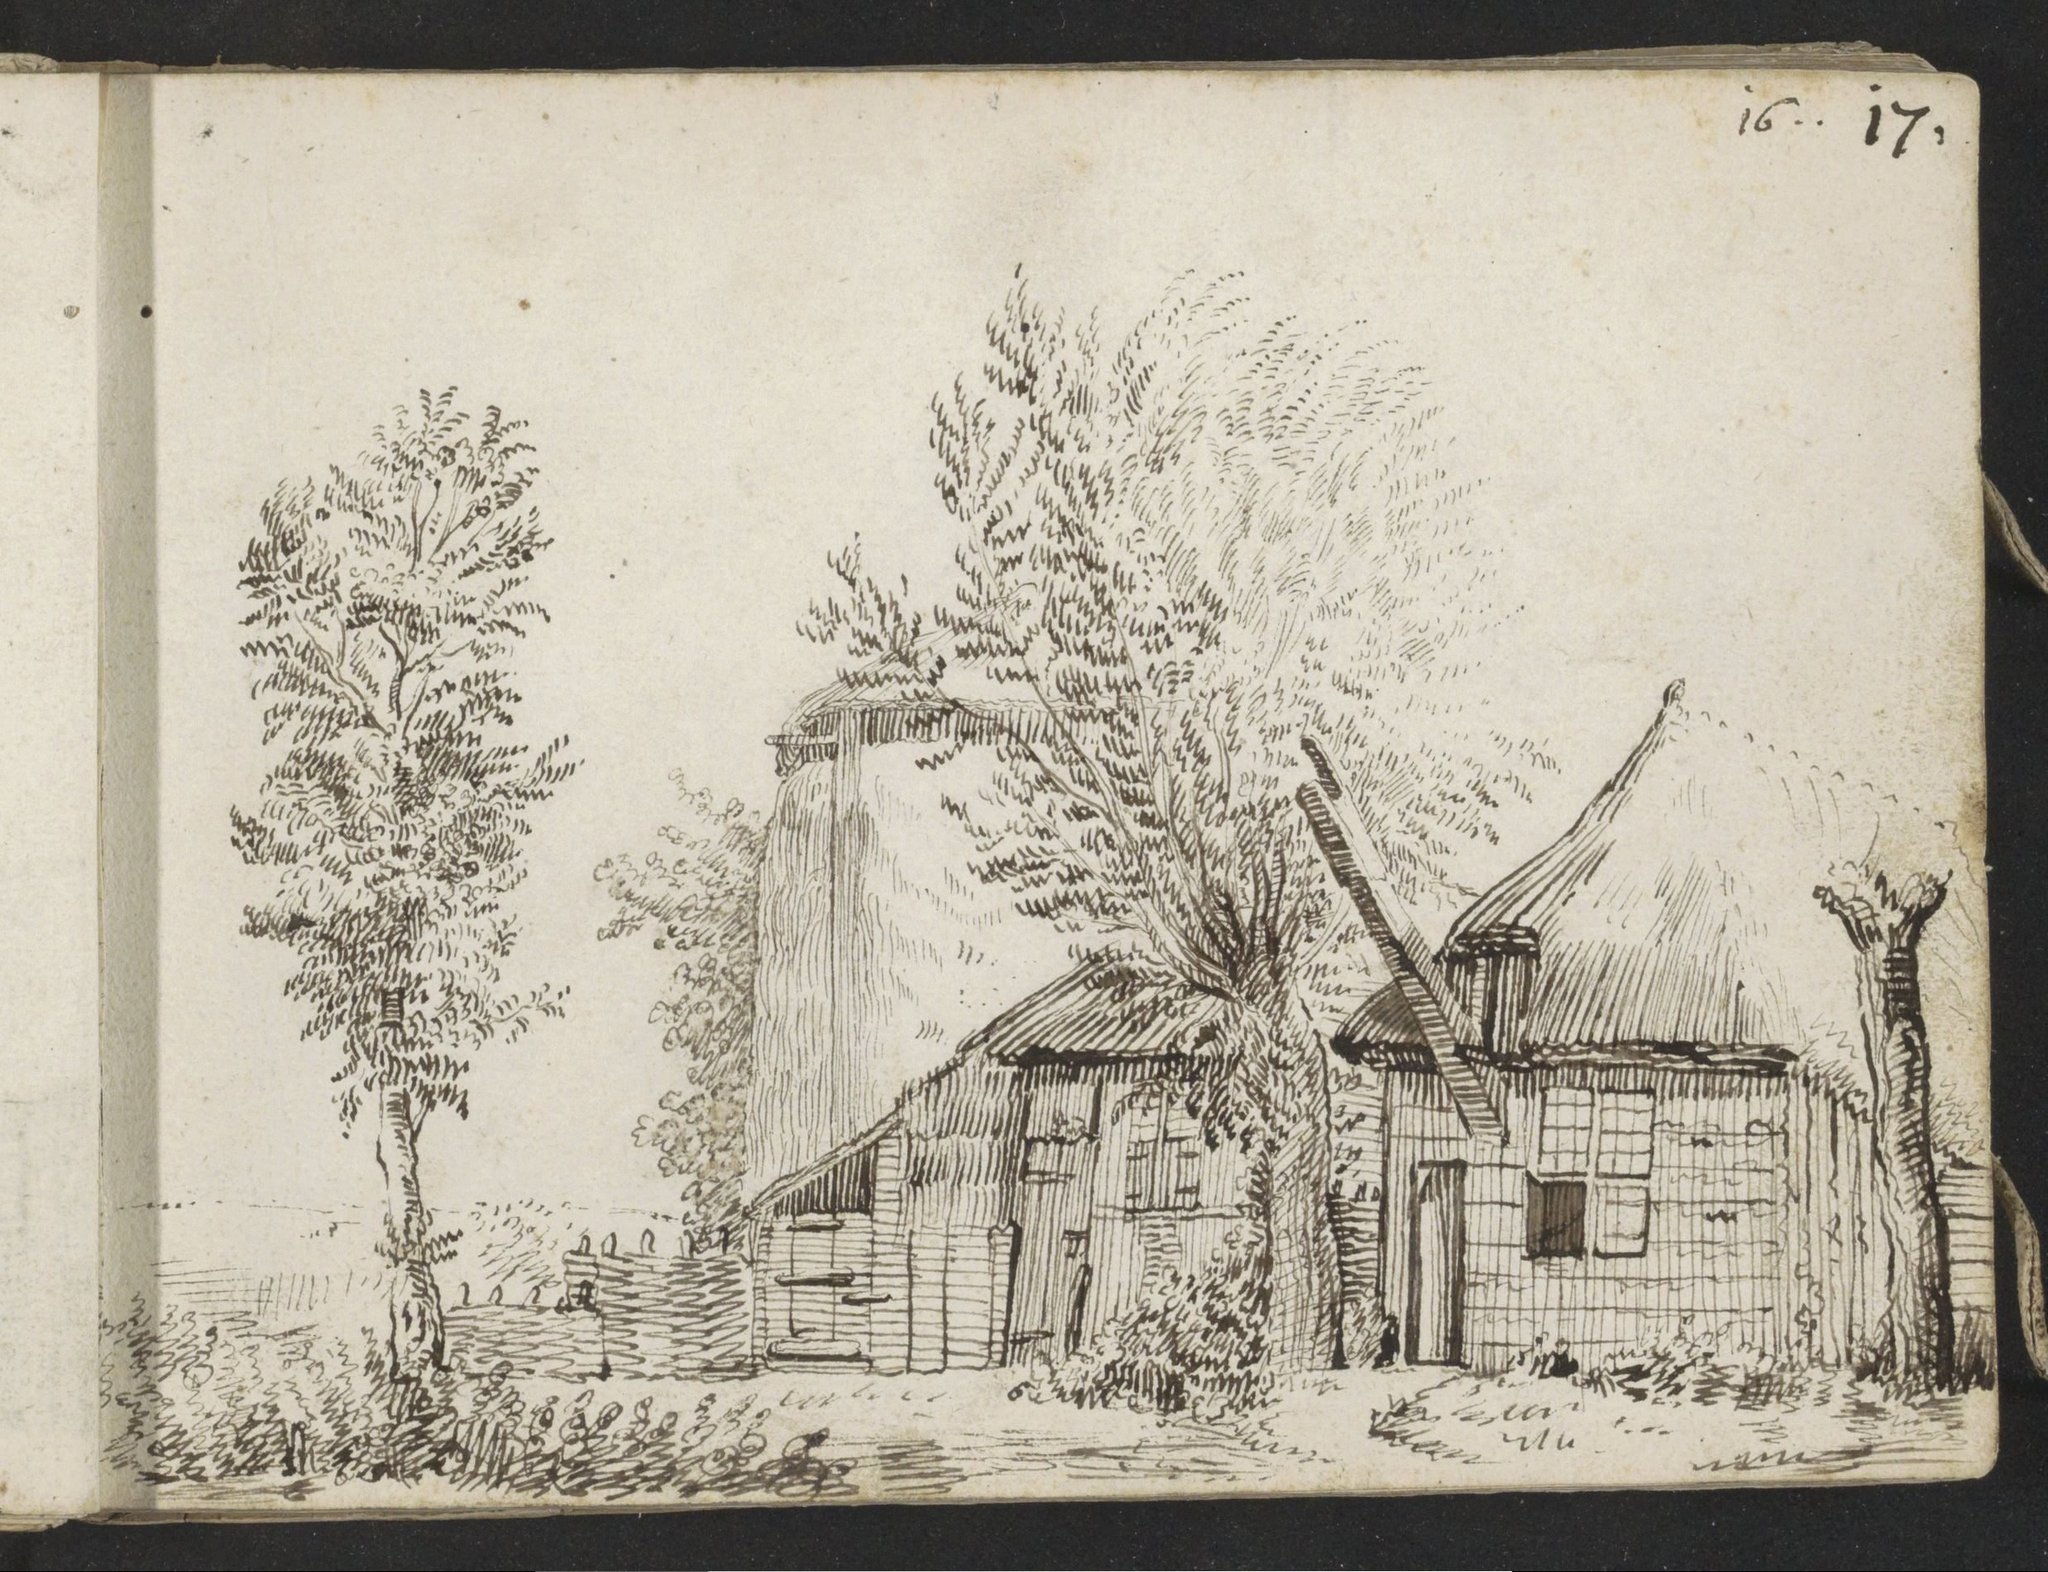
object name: sketchbook leaf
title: Boerenwoning, schuur en hooischuur buiten Zwolle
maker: gerard ter borch (ii)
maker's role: draughtsman, painter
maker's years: 1617-1681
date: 1631-1633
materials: ink, paper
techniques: pen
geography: zwolle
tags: hay-stack, farm (building)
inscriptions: number: ‘16..17.’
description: Het blad is rechtsboven genummerd: 16/17, voor en na het blad zijn bladen uit het schetsboek gehaald.